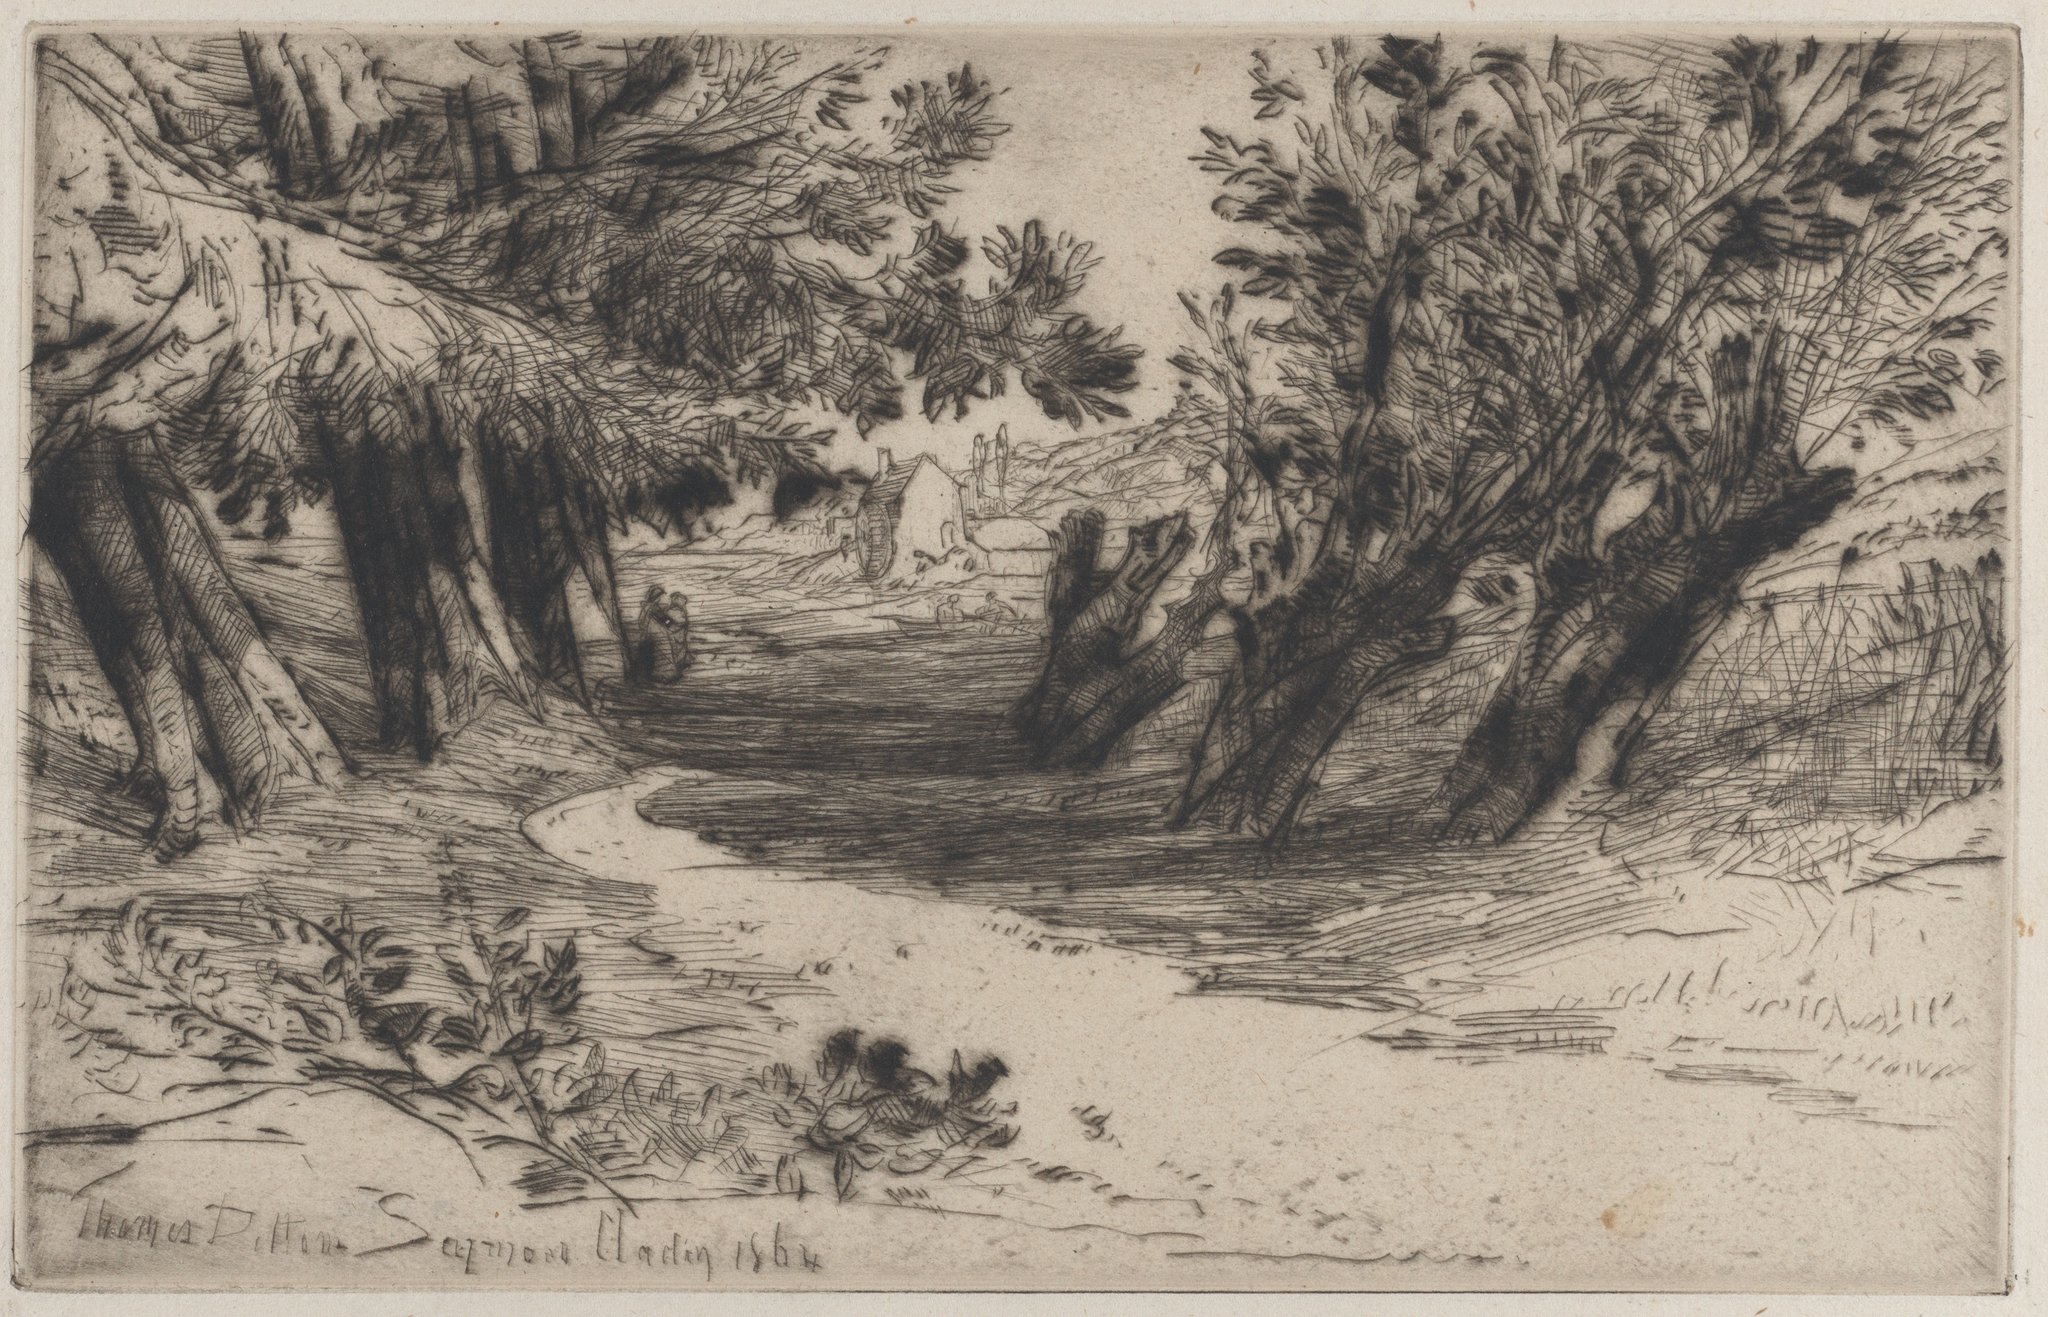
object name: print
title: The Lovers' Walk, No. 2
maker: francis seymour haden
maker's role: artist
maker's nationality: british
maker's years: 1818-1910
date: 1864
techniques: drypoint, etching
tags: landscapes